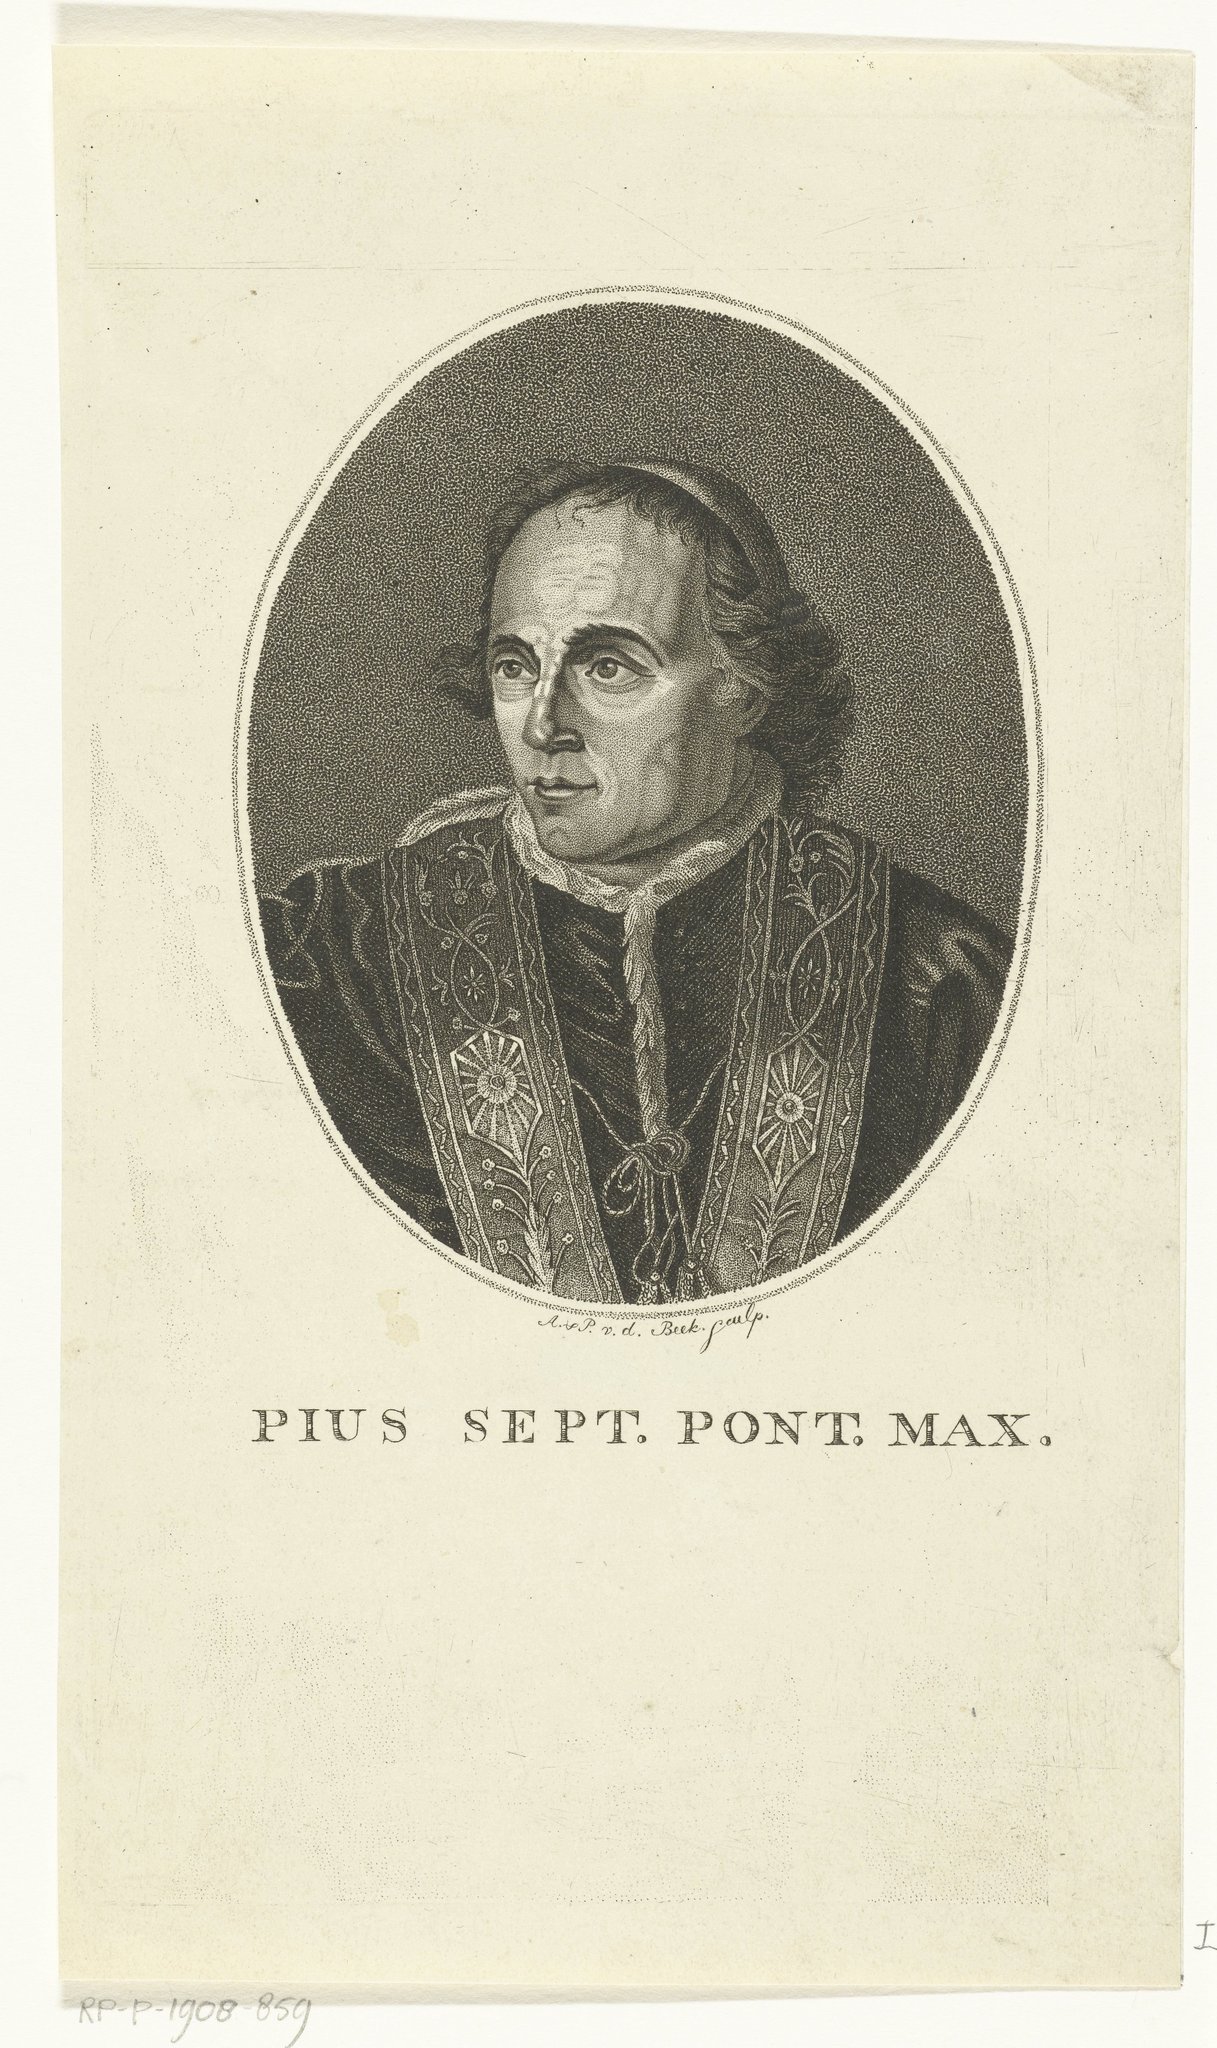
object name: print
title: Pius sept. pont. max.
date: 1795-1821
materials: paper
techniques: aquatint, etching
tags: rome, clergyman, pius vii, pope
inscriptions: collector's mark: Lugt 2228